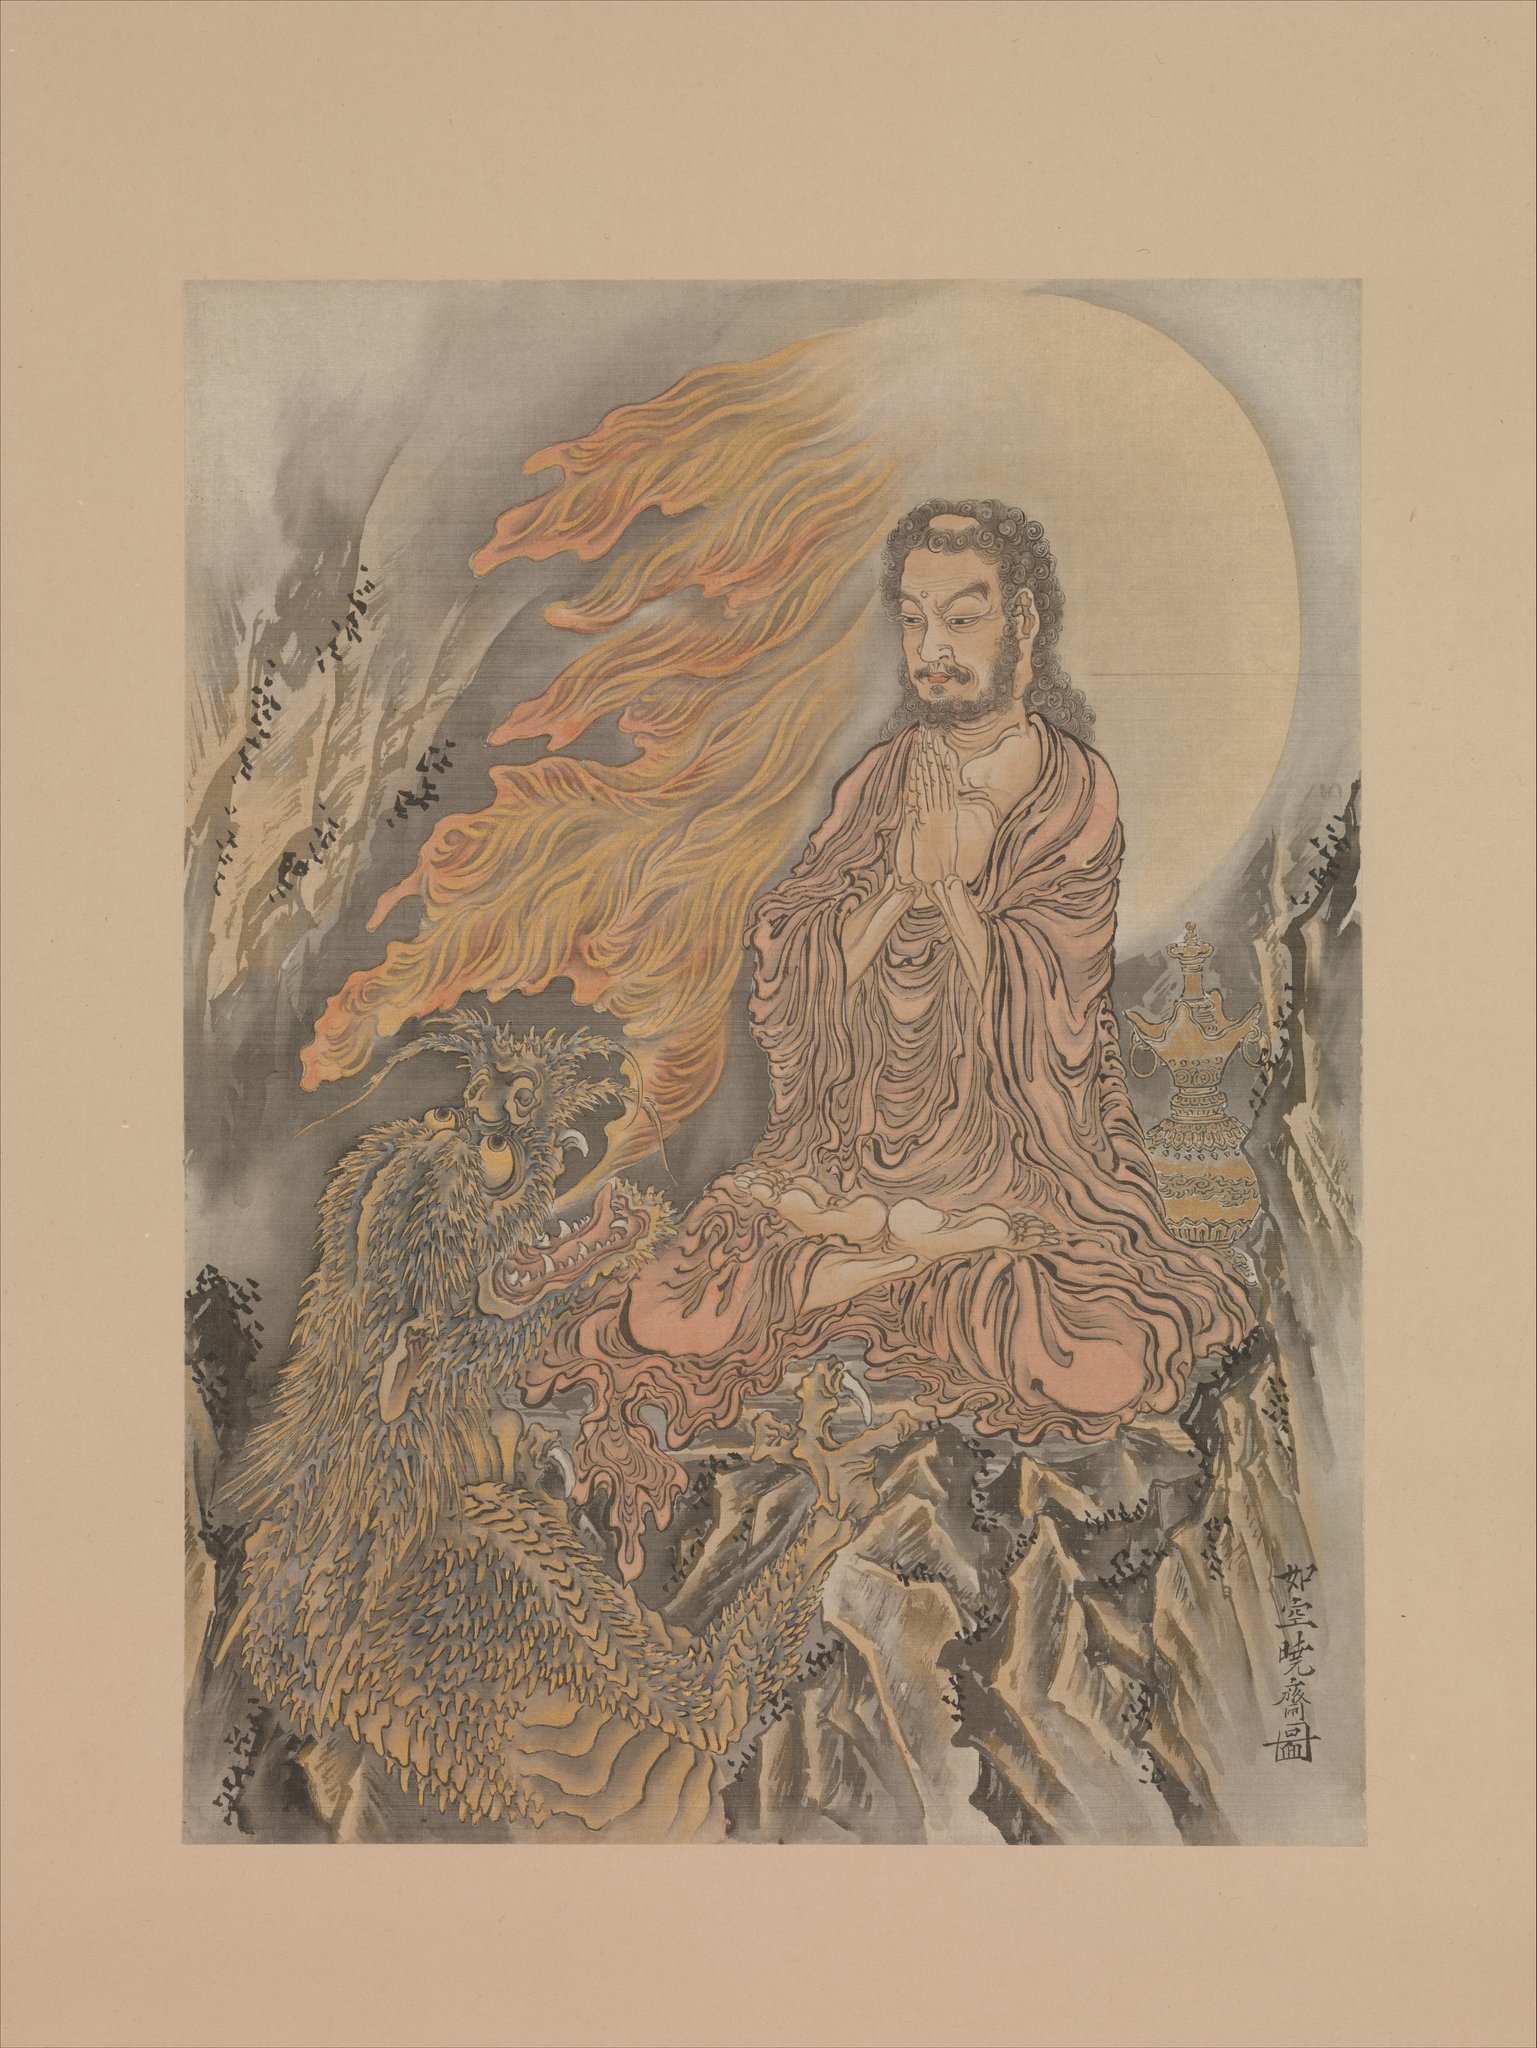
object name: hanging scroll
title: Shakyamuni Subjugating Demons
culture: japanese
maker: kawanabe kyōsai 河鍋暁斎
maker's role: artist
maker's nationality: japanese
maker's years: 1831-1889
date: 1888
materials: ink, silk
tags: dragons,buddhism,shakyamuni